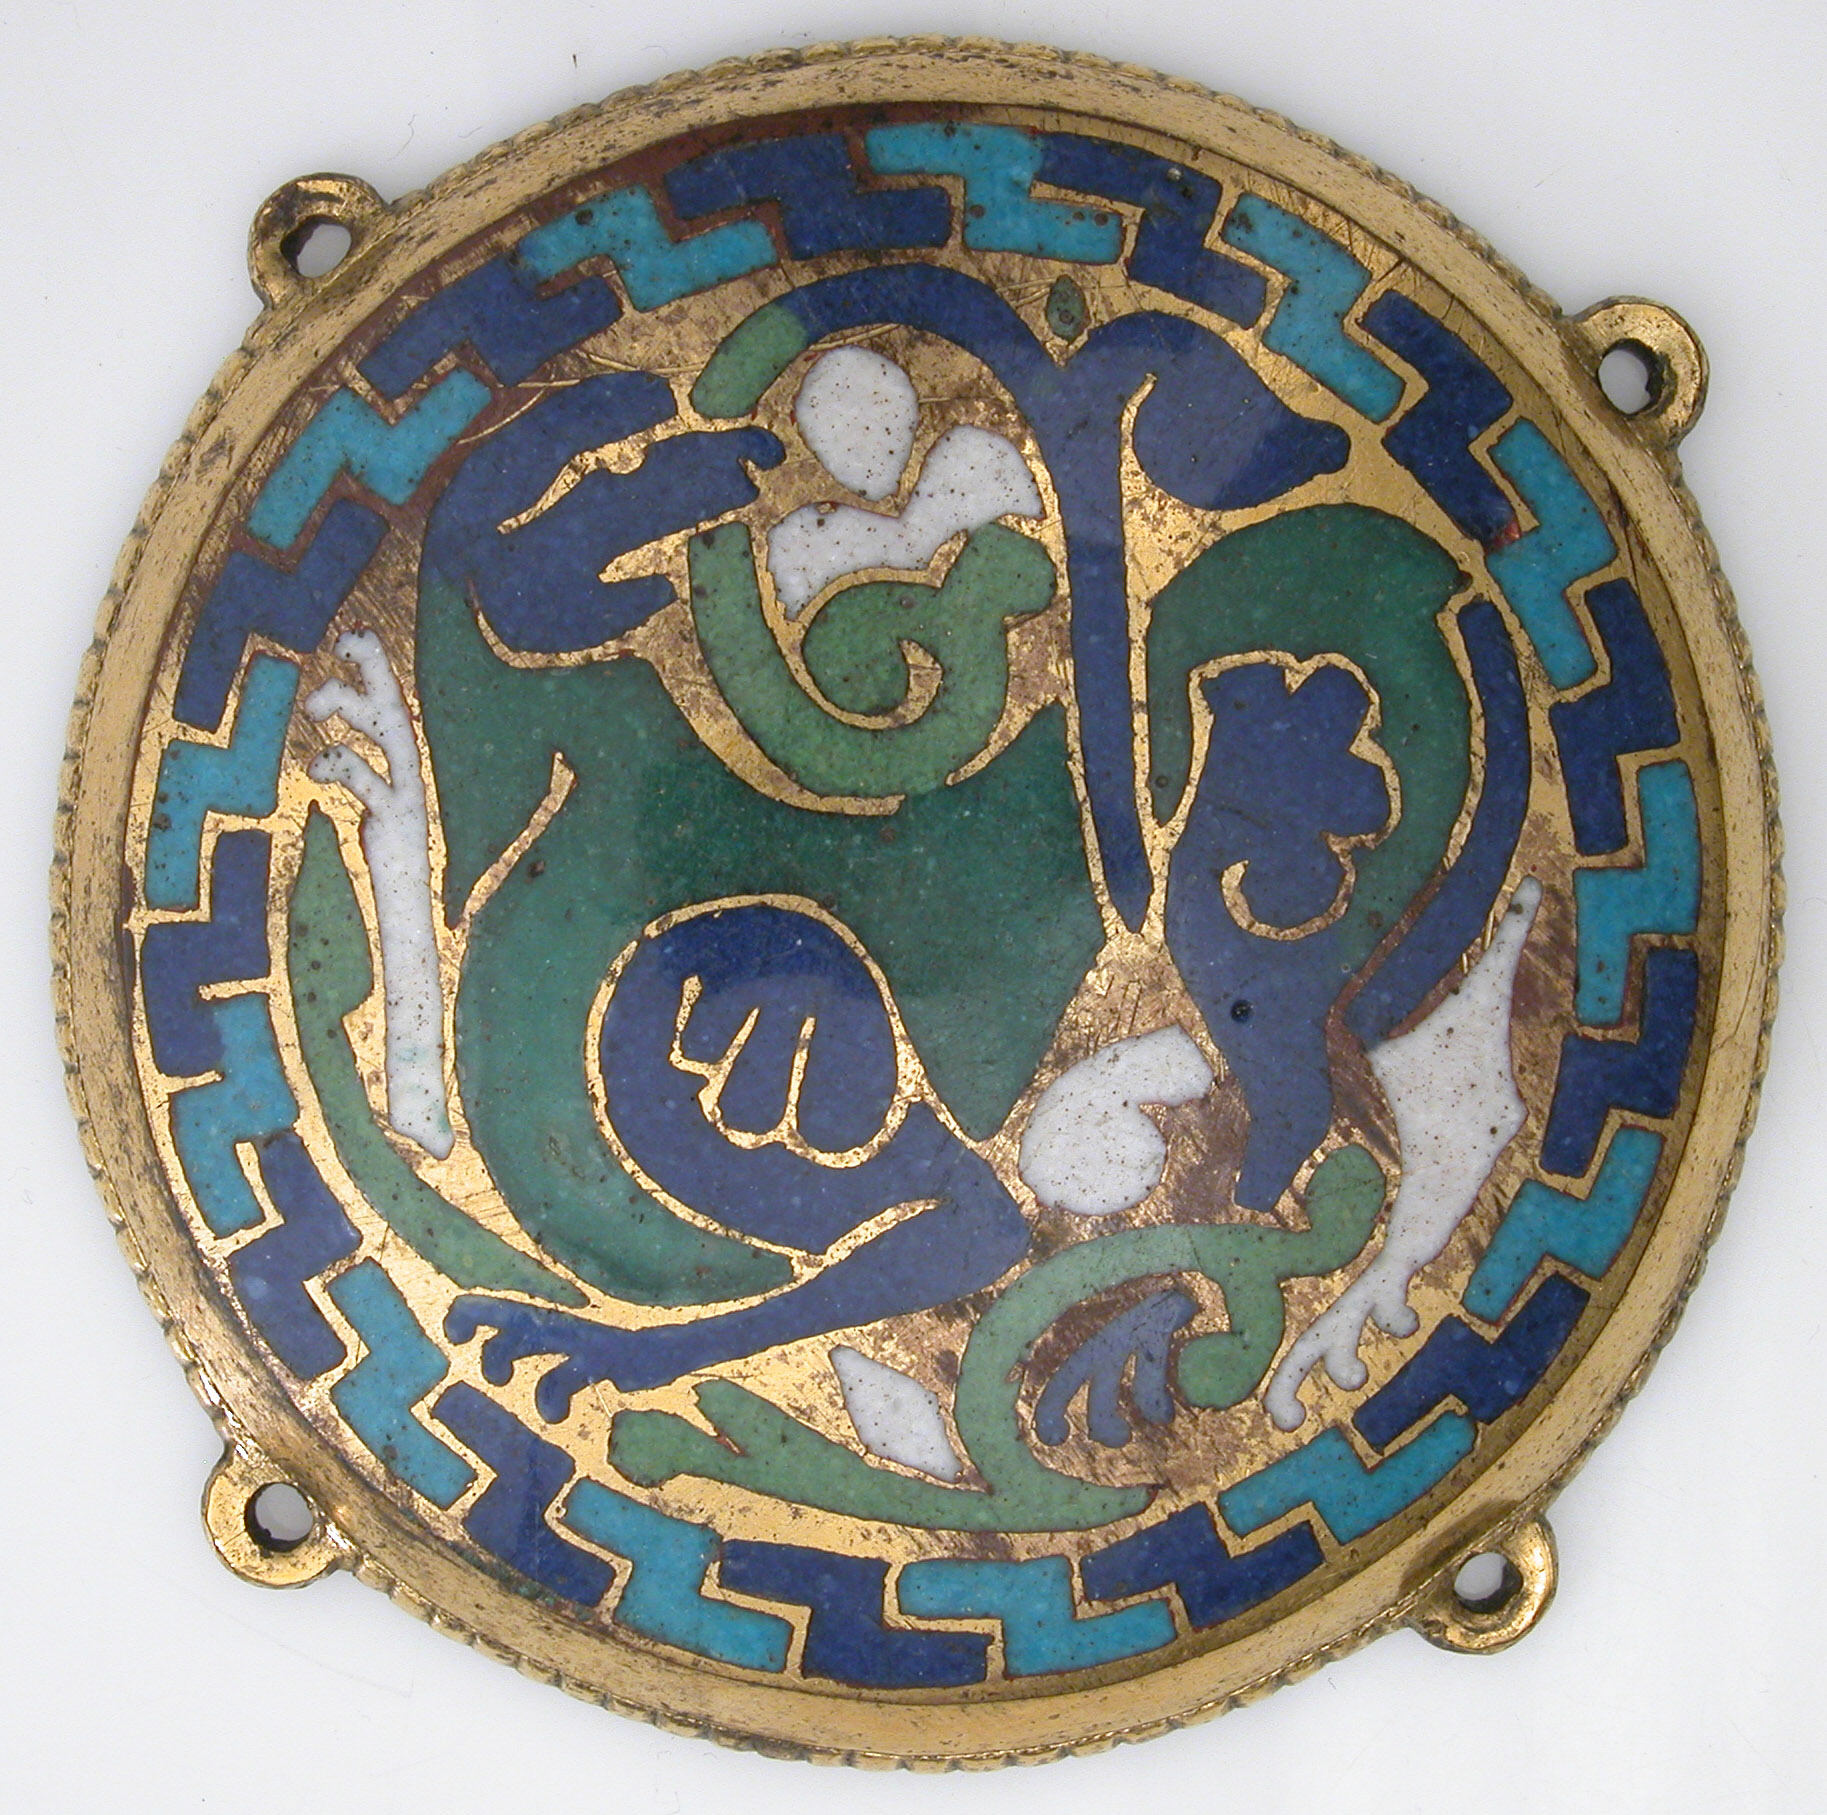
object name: medallion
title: Quadruped (one of five medallions from a coffret)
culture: french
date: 1110-1130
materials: gilt copper, enamel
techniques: enamel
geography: france